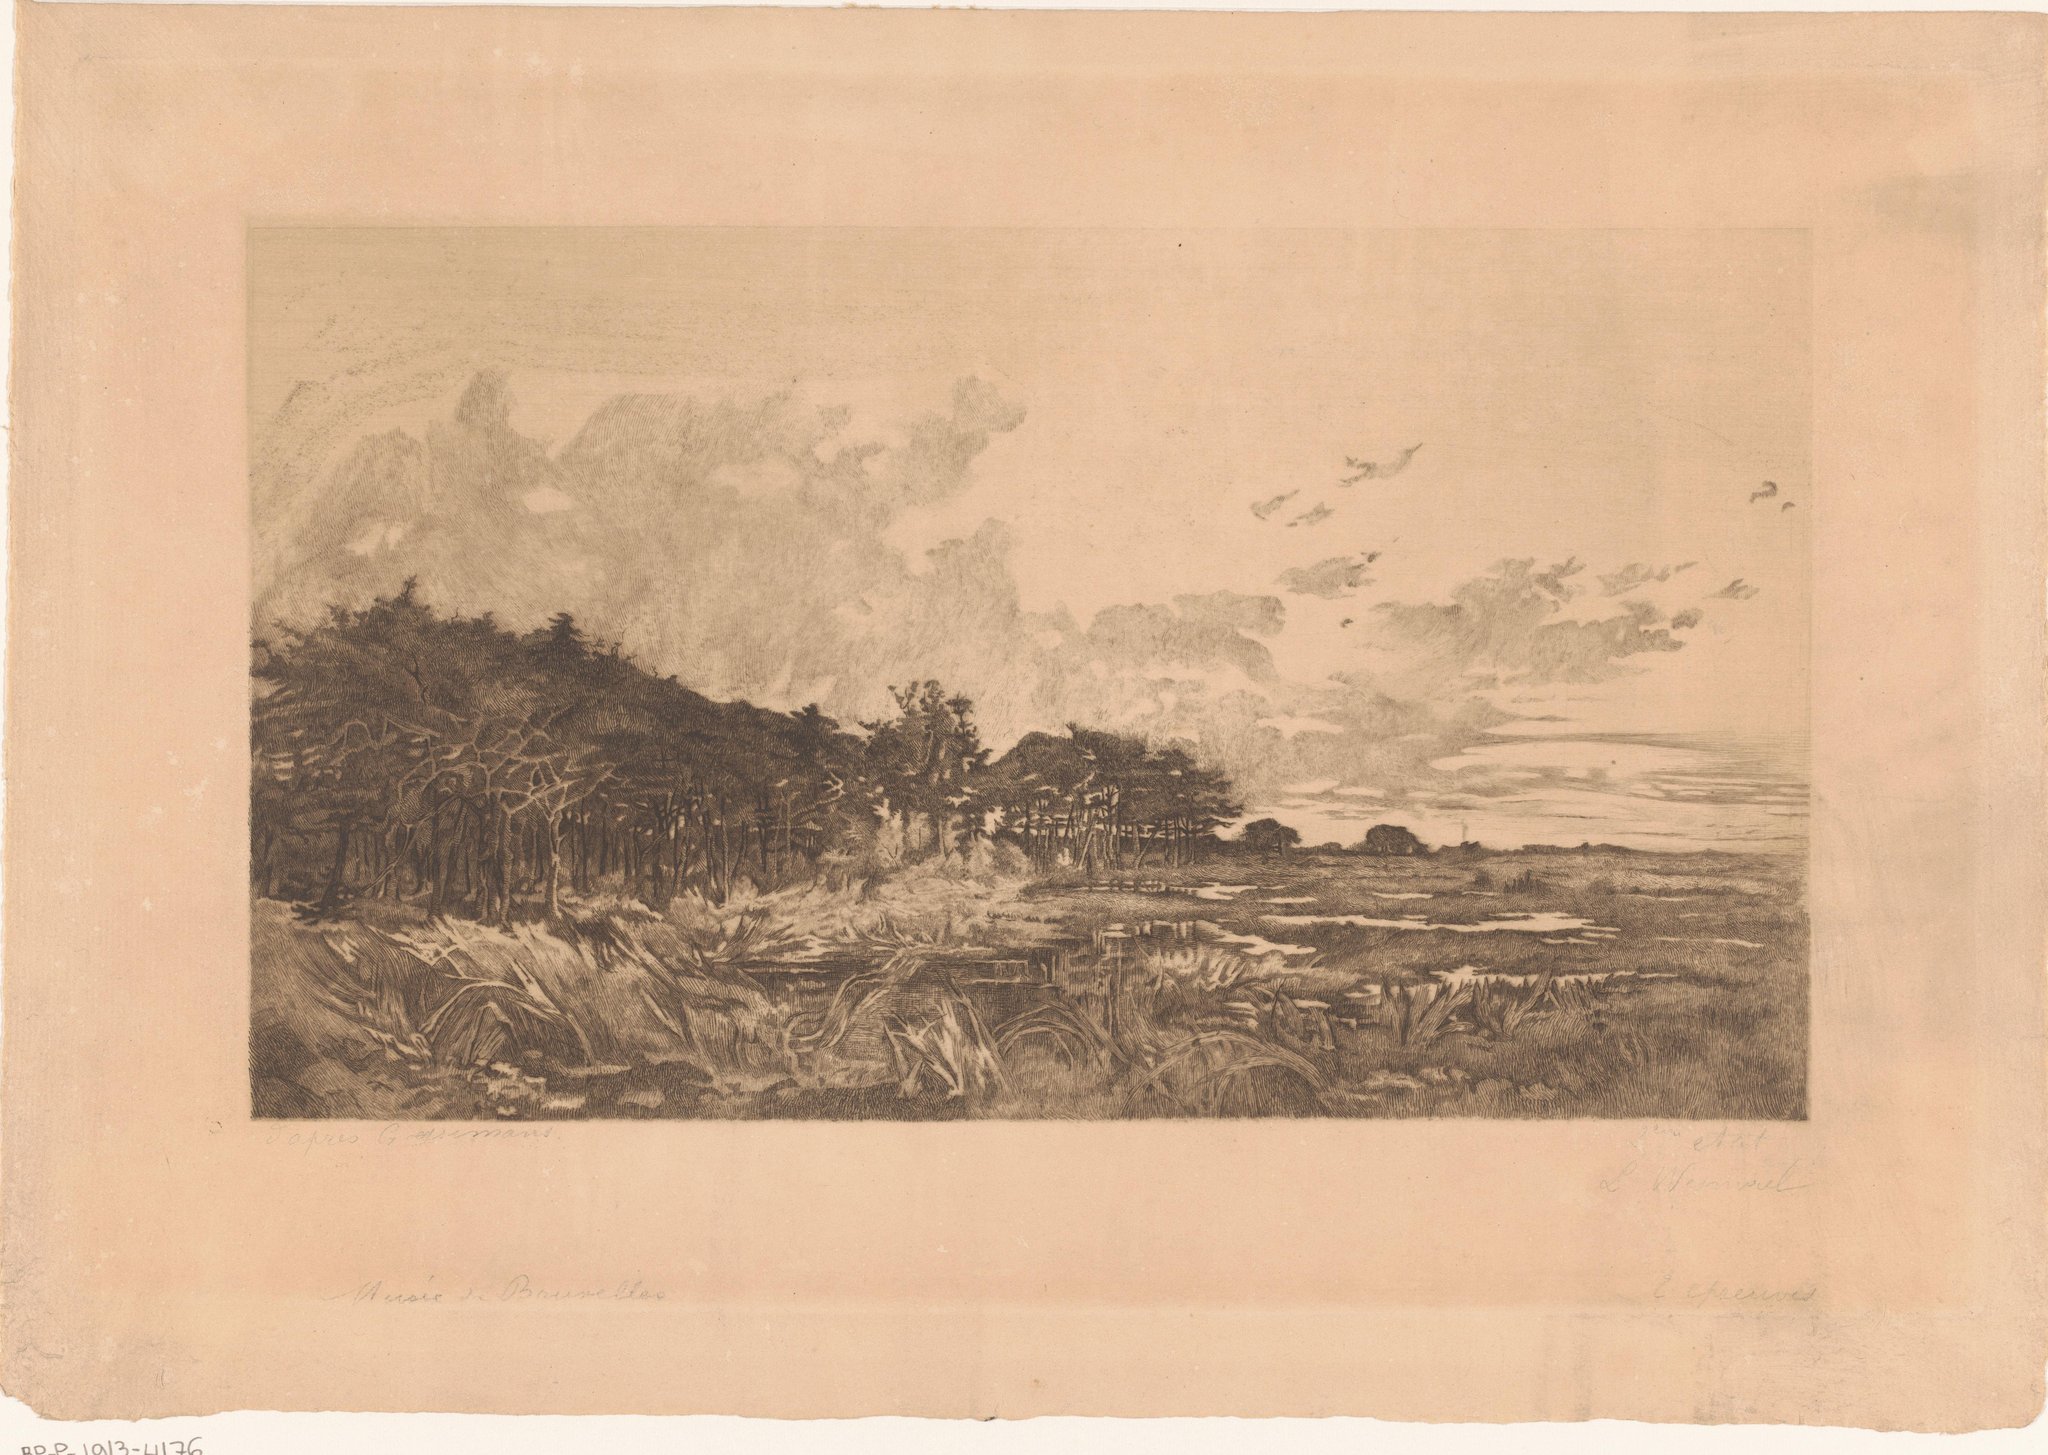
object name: print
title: Landschap met bomen langs een moeras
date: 1883-1913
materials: paper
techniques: drypoint, etching, intaglio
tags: swamp, inland marsh, fens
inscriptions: watermark, collector's mark: Lugt 2228